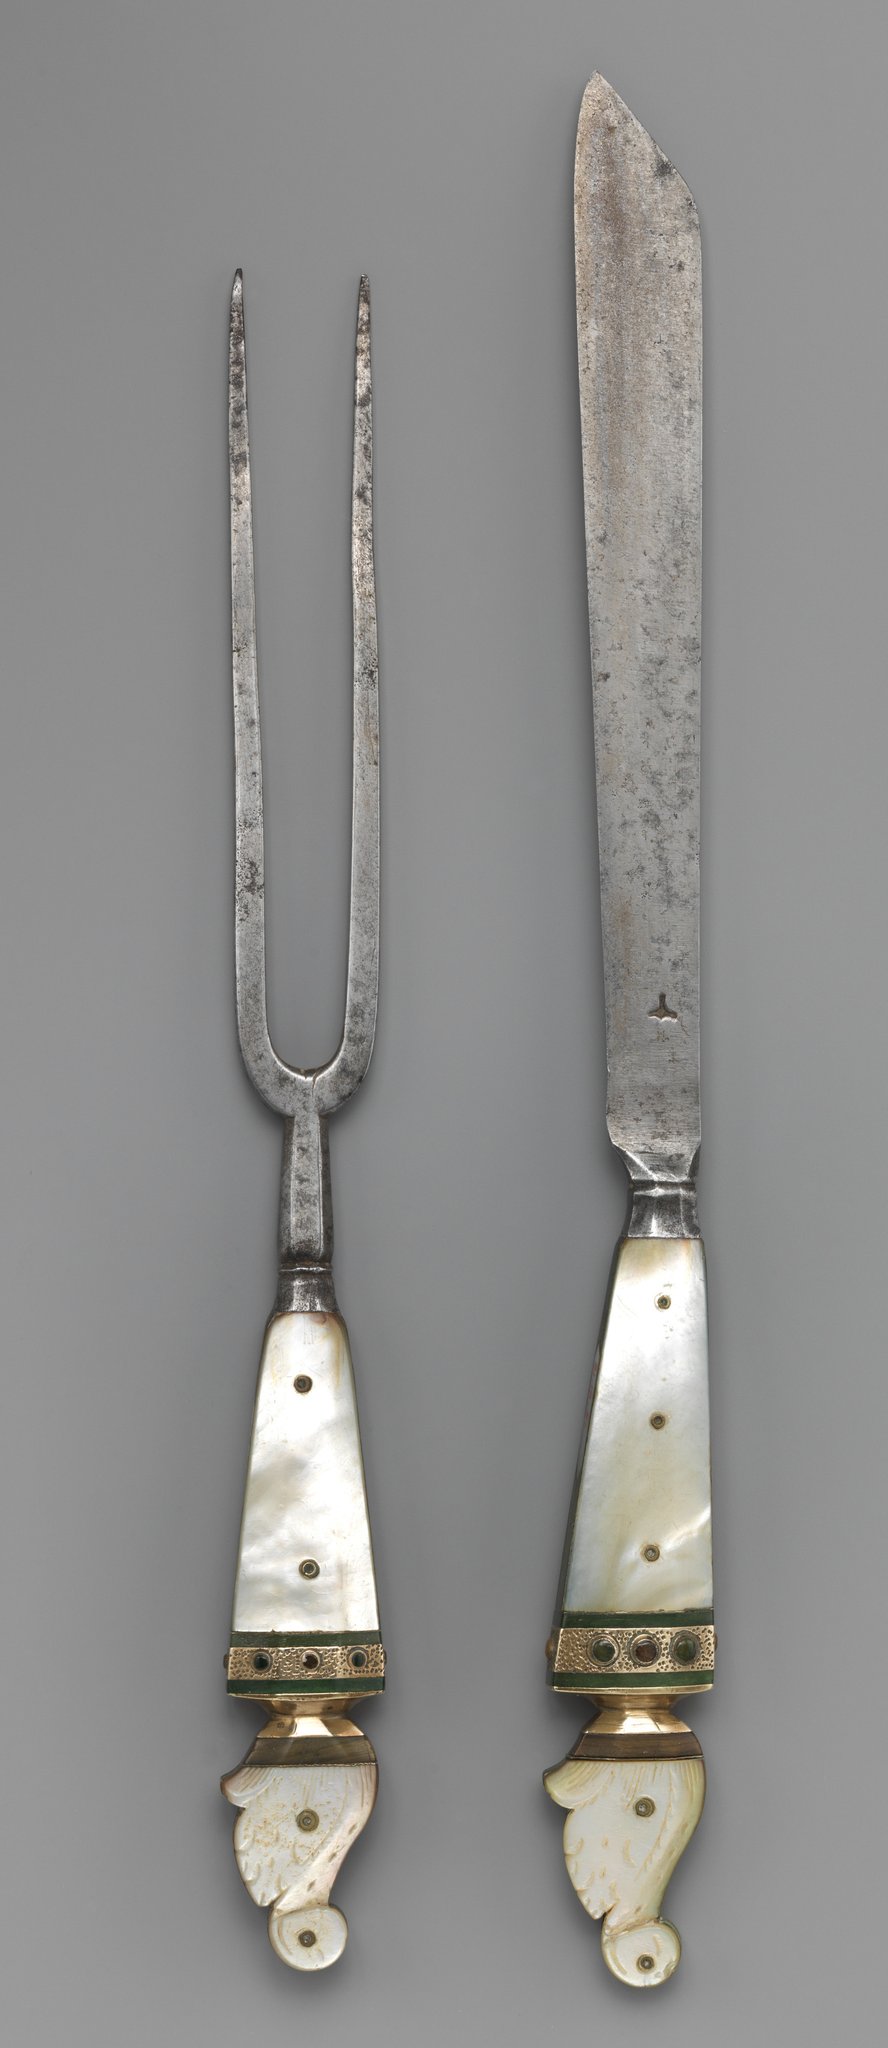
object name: table knife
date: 1700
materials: brass, horn, mother of pearl, steel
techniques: stain